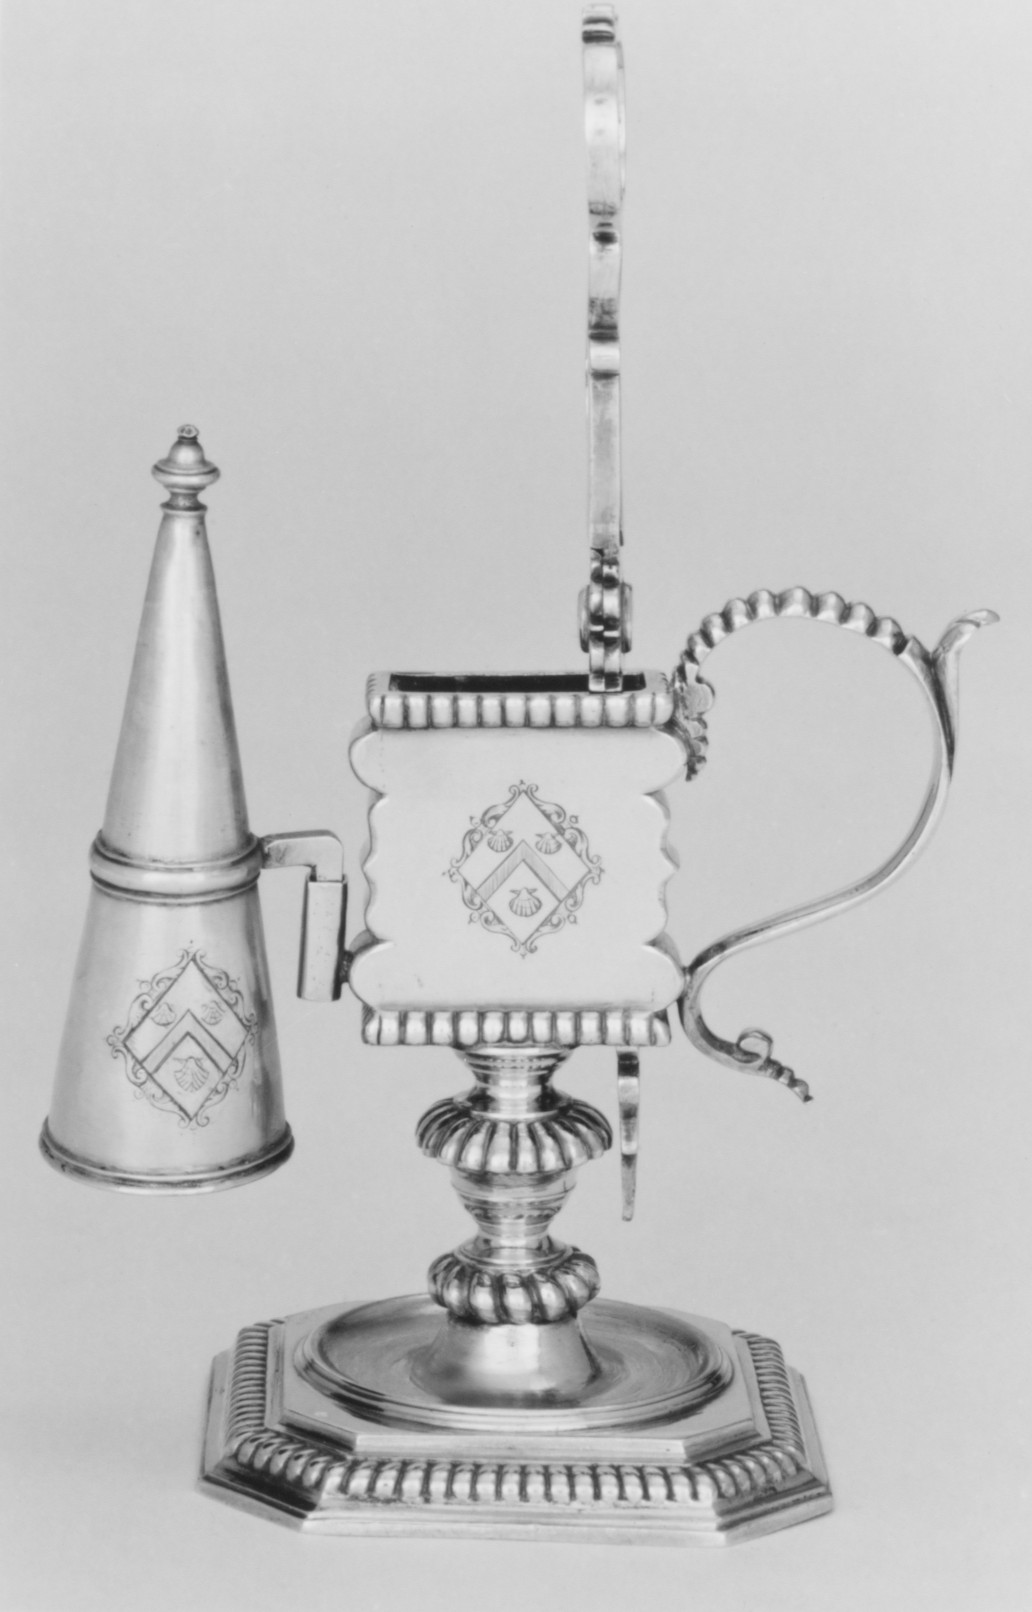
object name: snuffer, extinguisher and stand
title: Snuffers, extinguisher and stand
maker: b. or j. b., london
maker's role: maker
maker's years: 1656-1695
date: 1694-1695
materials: silver gilt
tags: coat of arms